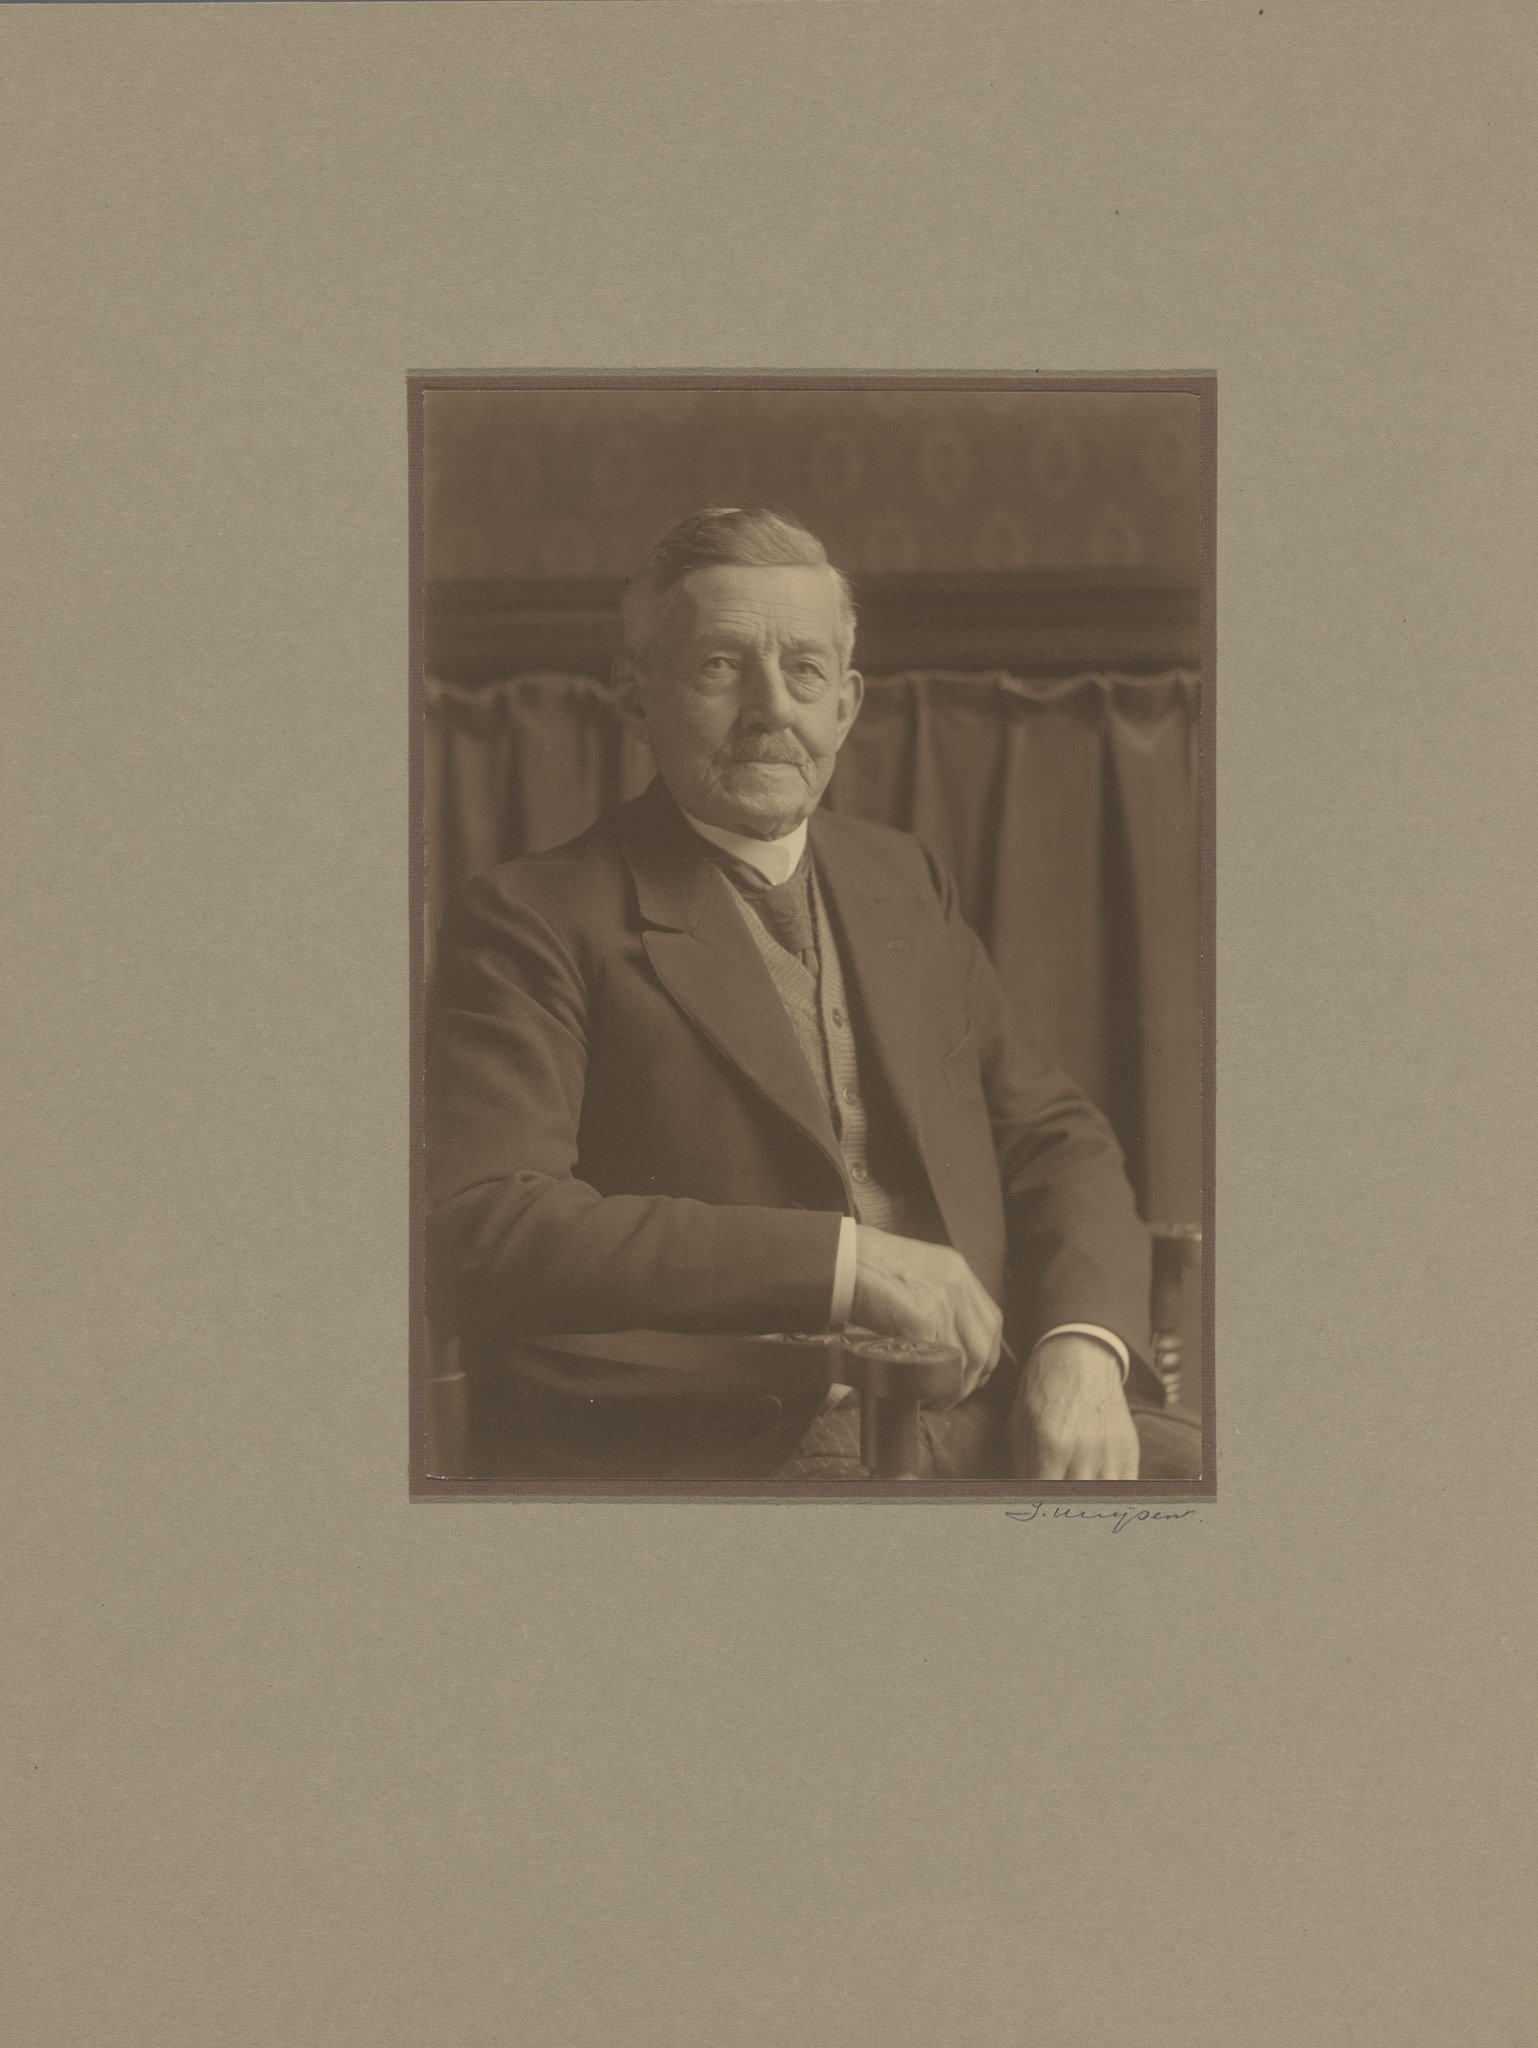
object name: photograph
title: Portret van een onbekende man, vermoedelijk Martinus Marmelstein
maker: j. kuipers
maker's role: fotograaf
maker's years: 1845-1925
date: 1900-1940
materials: paper, cardboard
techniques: gelatin silver print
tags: adult man, historical persons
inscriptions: inscription: ‘Martinus Marmelstein’, signature: ‘J. Kuipers’